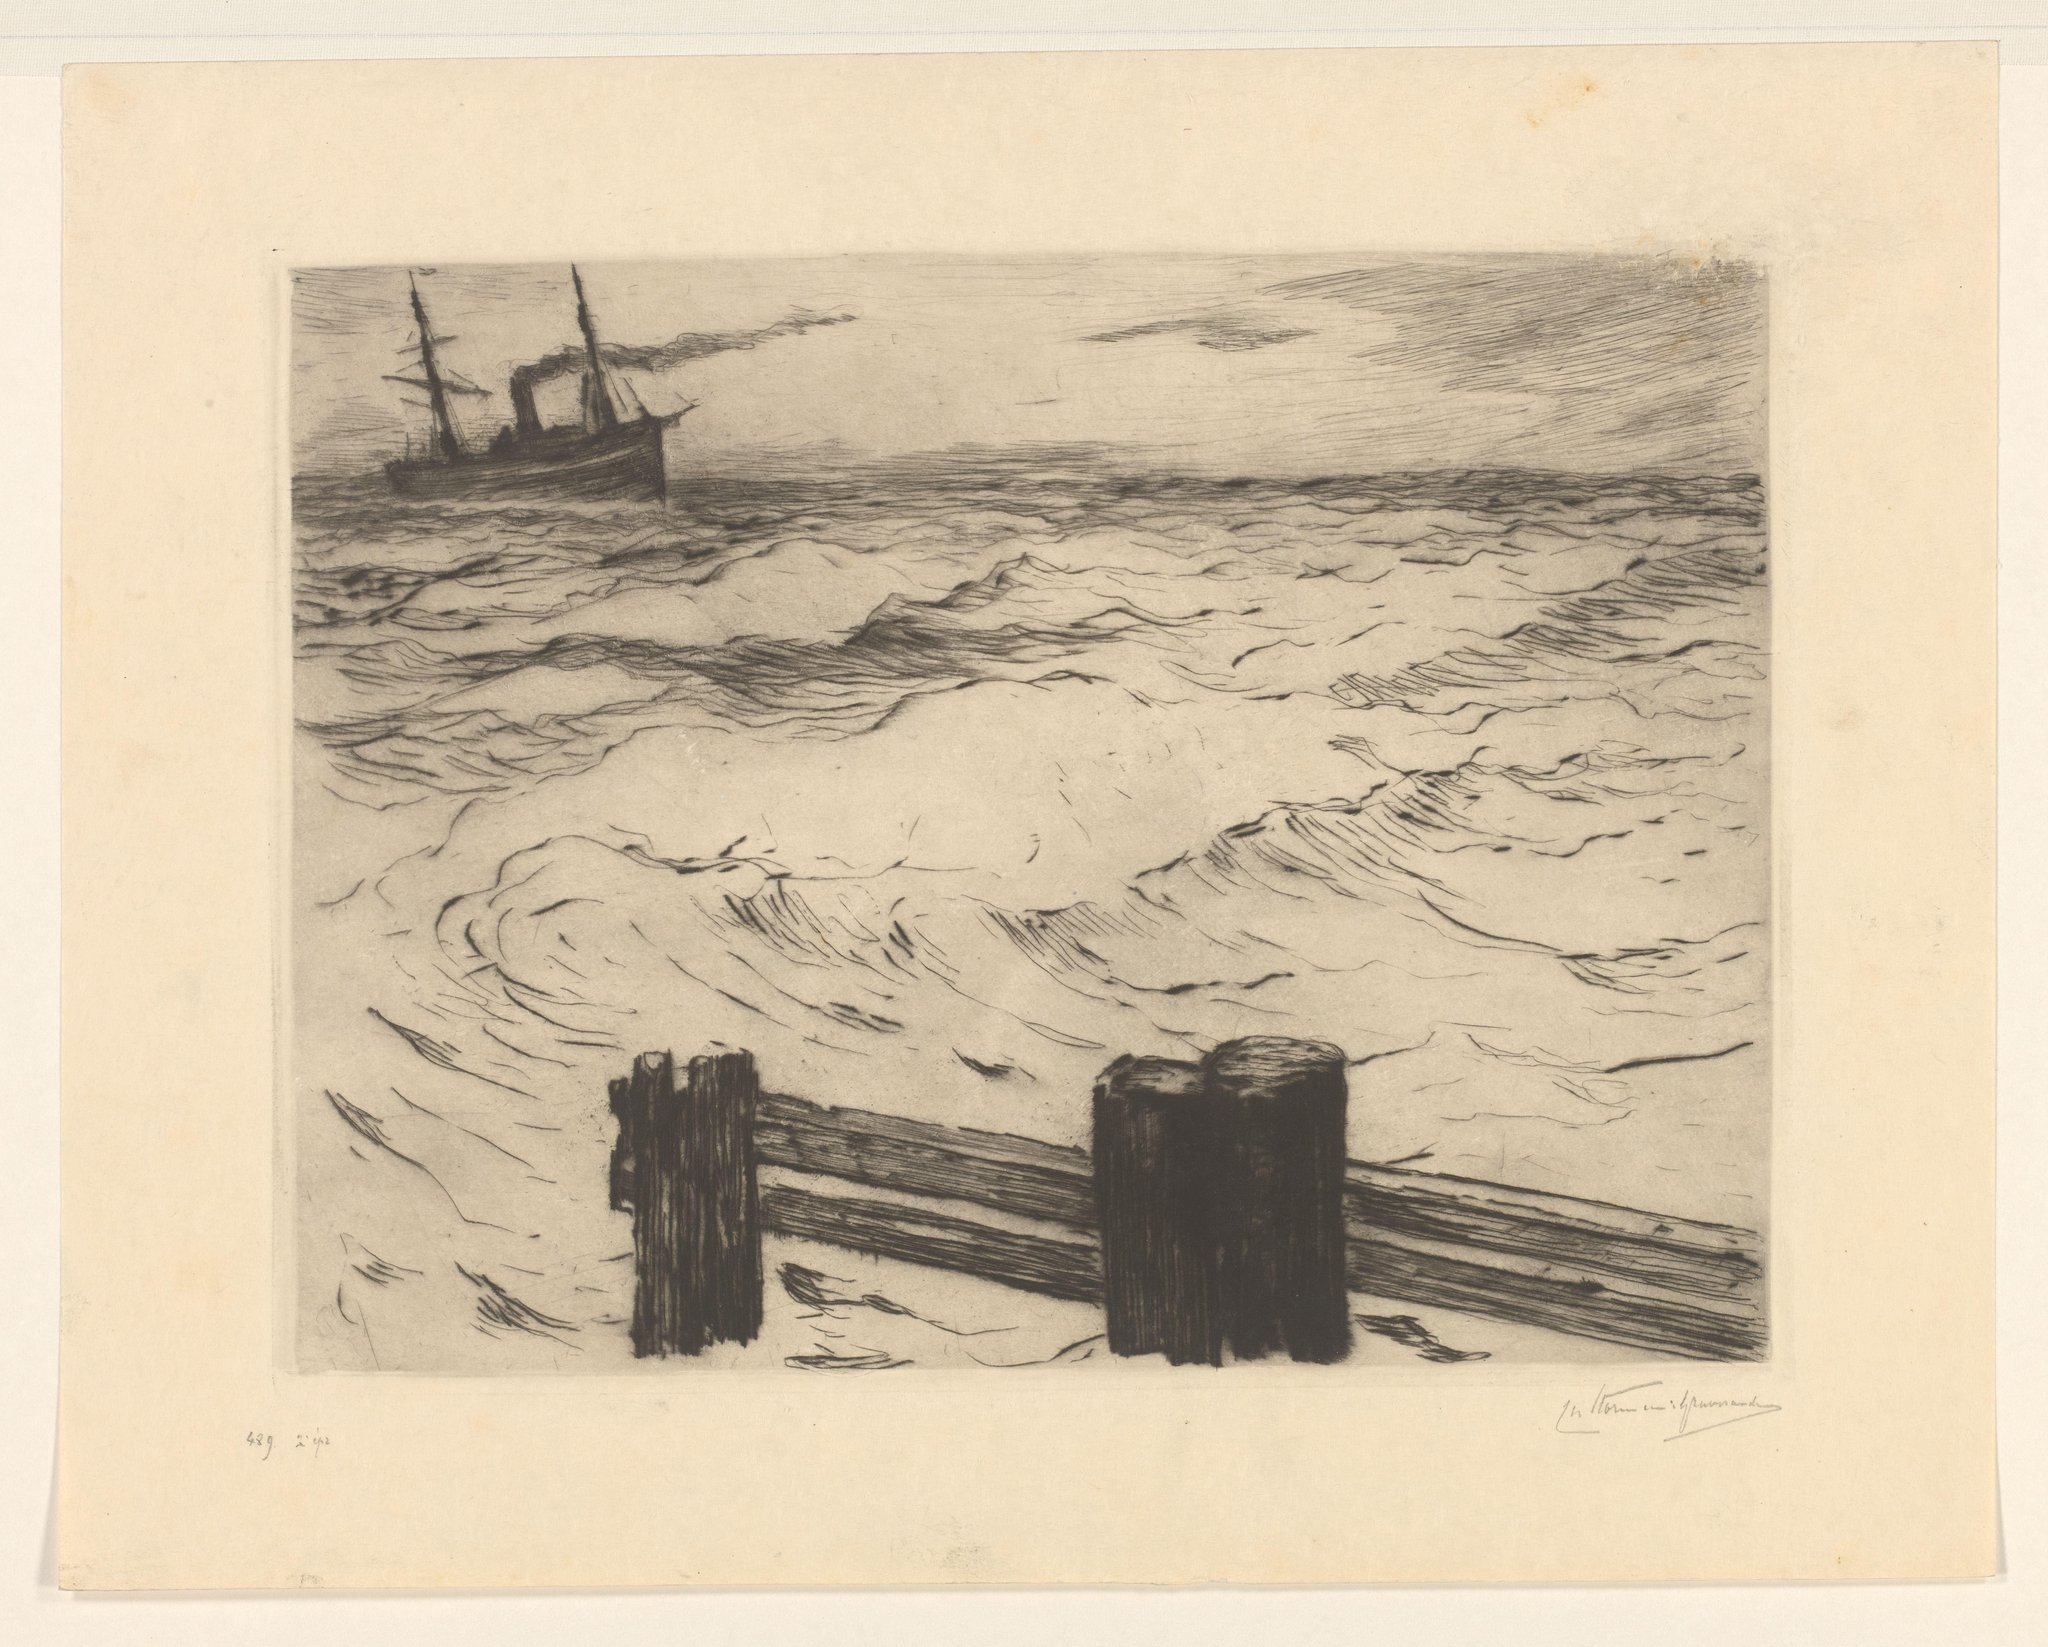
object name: print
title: Stoomschip op zee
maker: carel nicolaas storm van s-gravesande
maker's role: draughtsman, print maker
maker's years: 1841-1924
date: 1851-1924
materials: paper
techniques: drypoint, intaglio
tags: steamship, motorship, sea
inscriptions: collector's mark: Lugt 2228